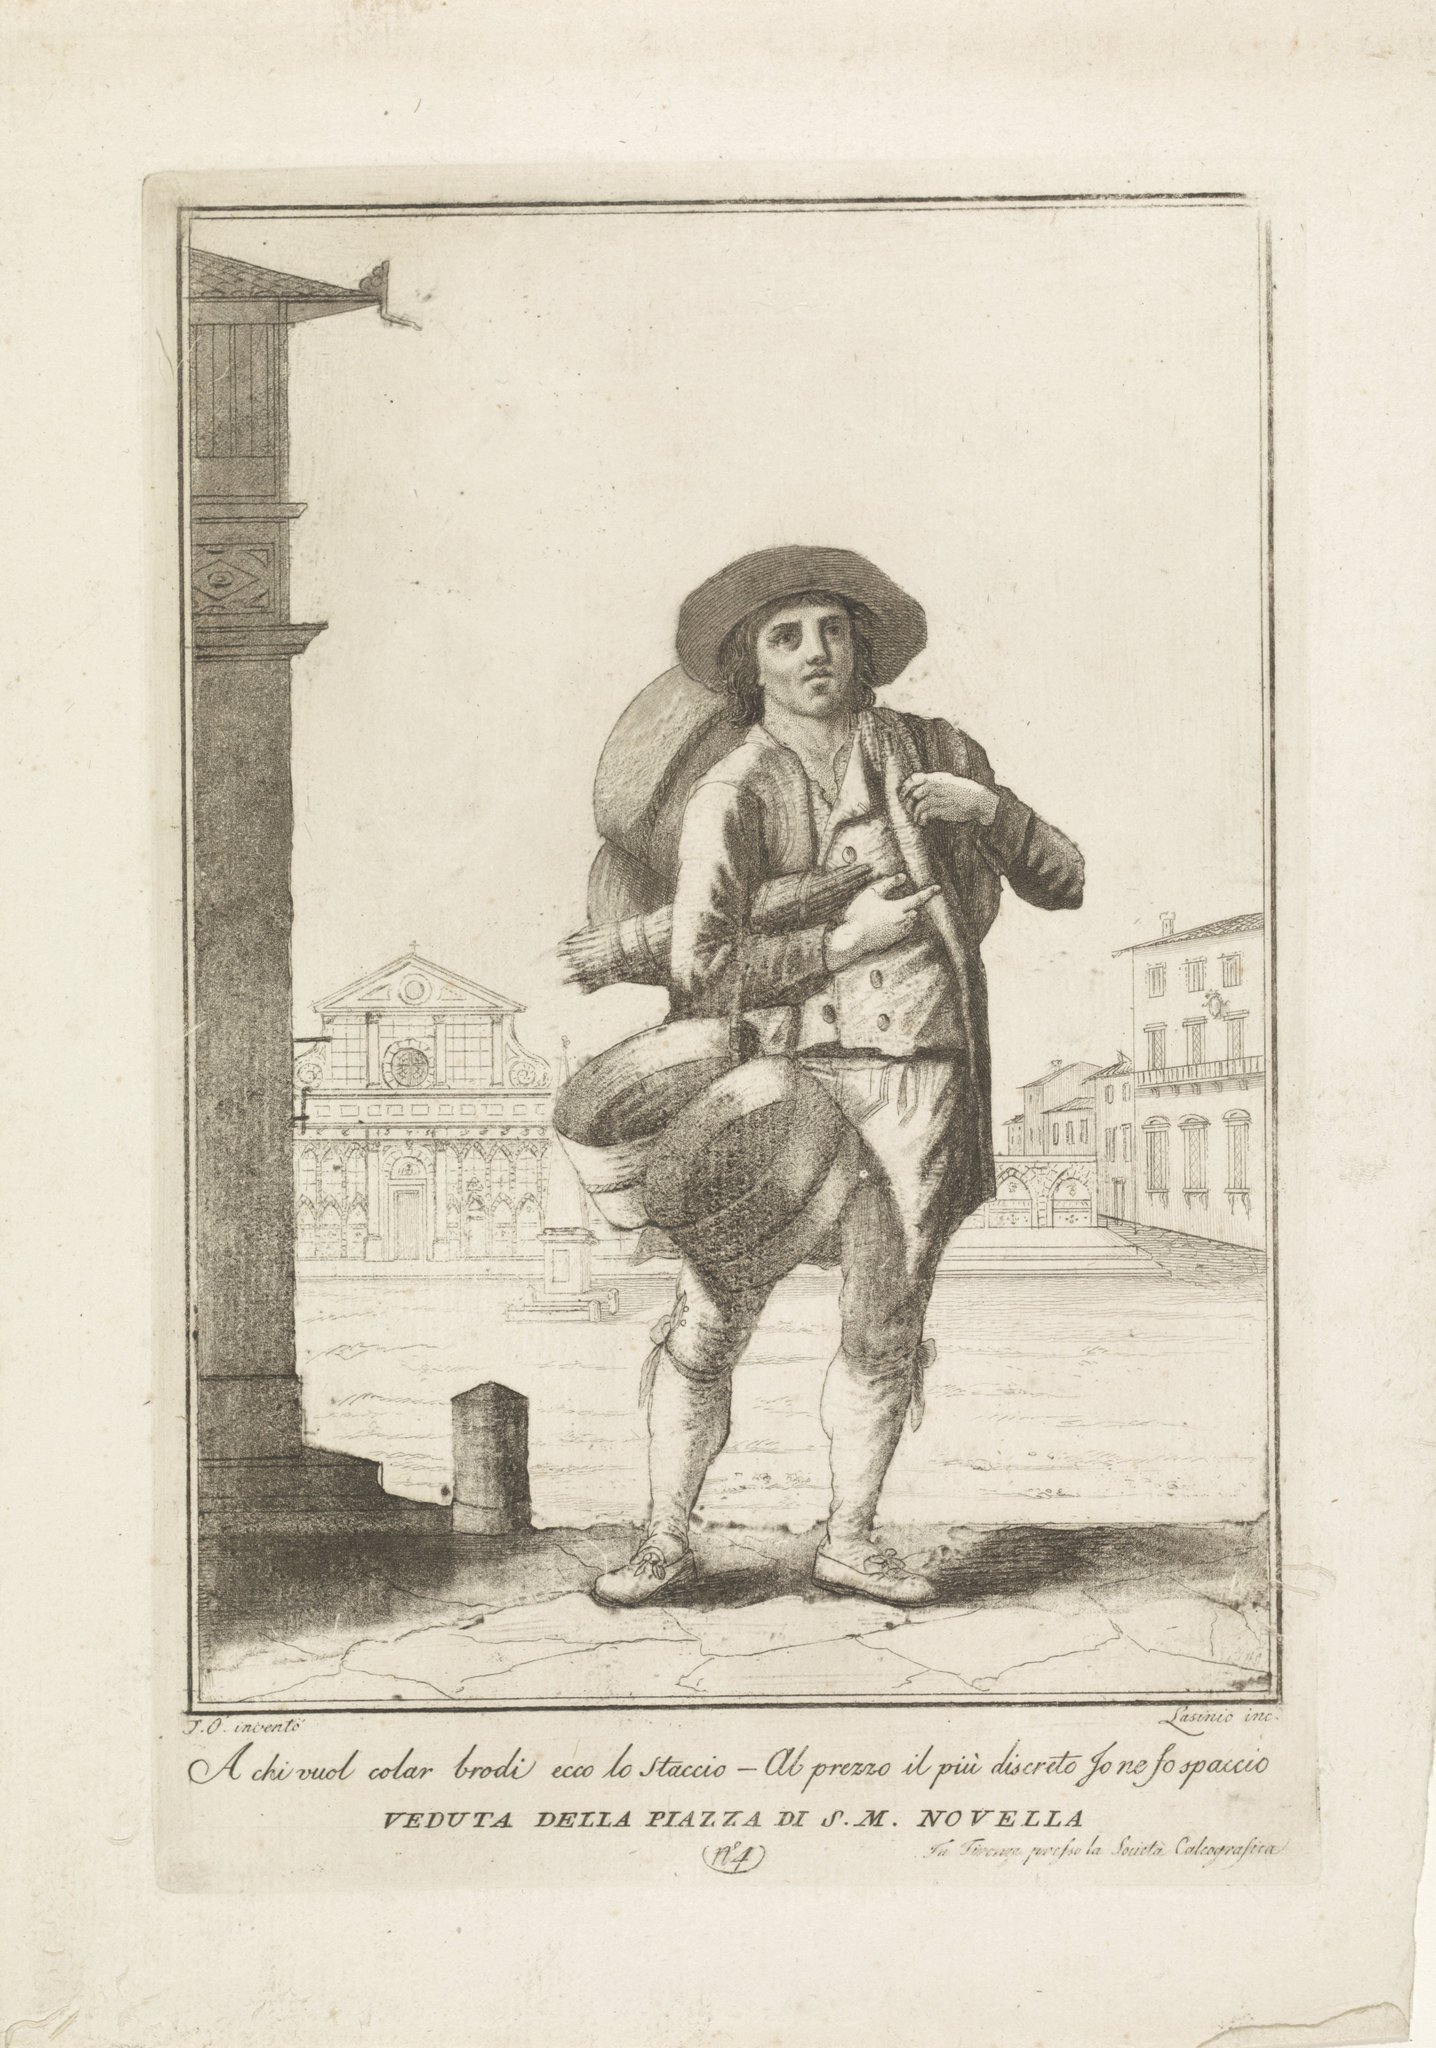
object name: print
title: Verkoper van zeven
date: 1769-1838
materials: paper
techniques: etching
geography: italy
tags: kitchen-utensils: sieve, street-trader, merchant, salesman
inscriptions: collector's mark: Lugt 2760, collector's mark: Lugt 2228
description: Een verkoper van zeven op het Piazza Santa Maria Novella in Florence. Hij loopt met zeven onder de arm en op de rug en een bundel stokken onder zijn arm. Italiaanse tekst in ondermarge.